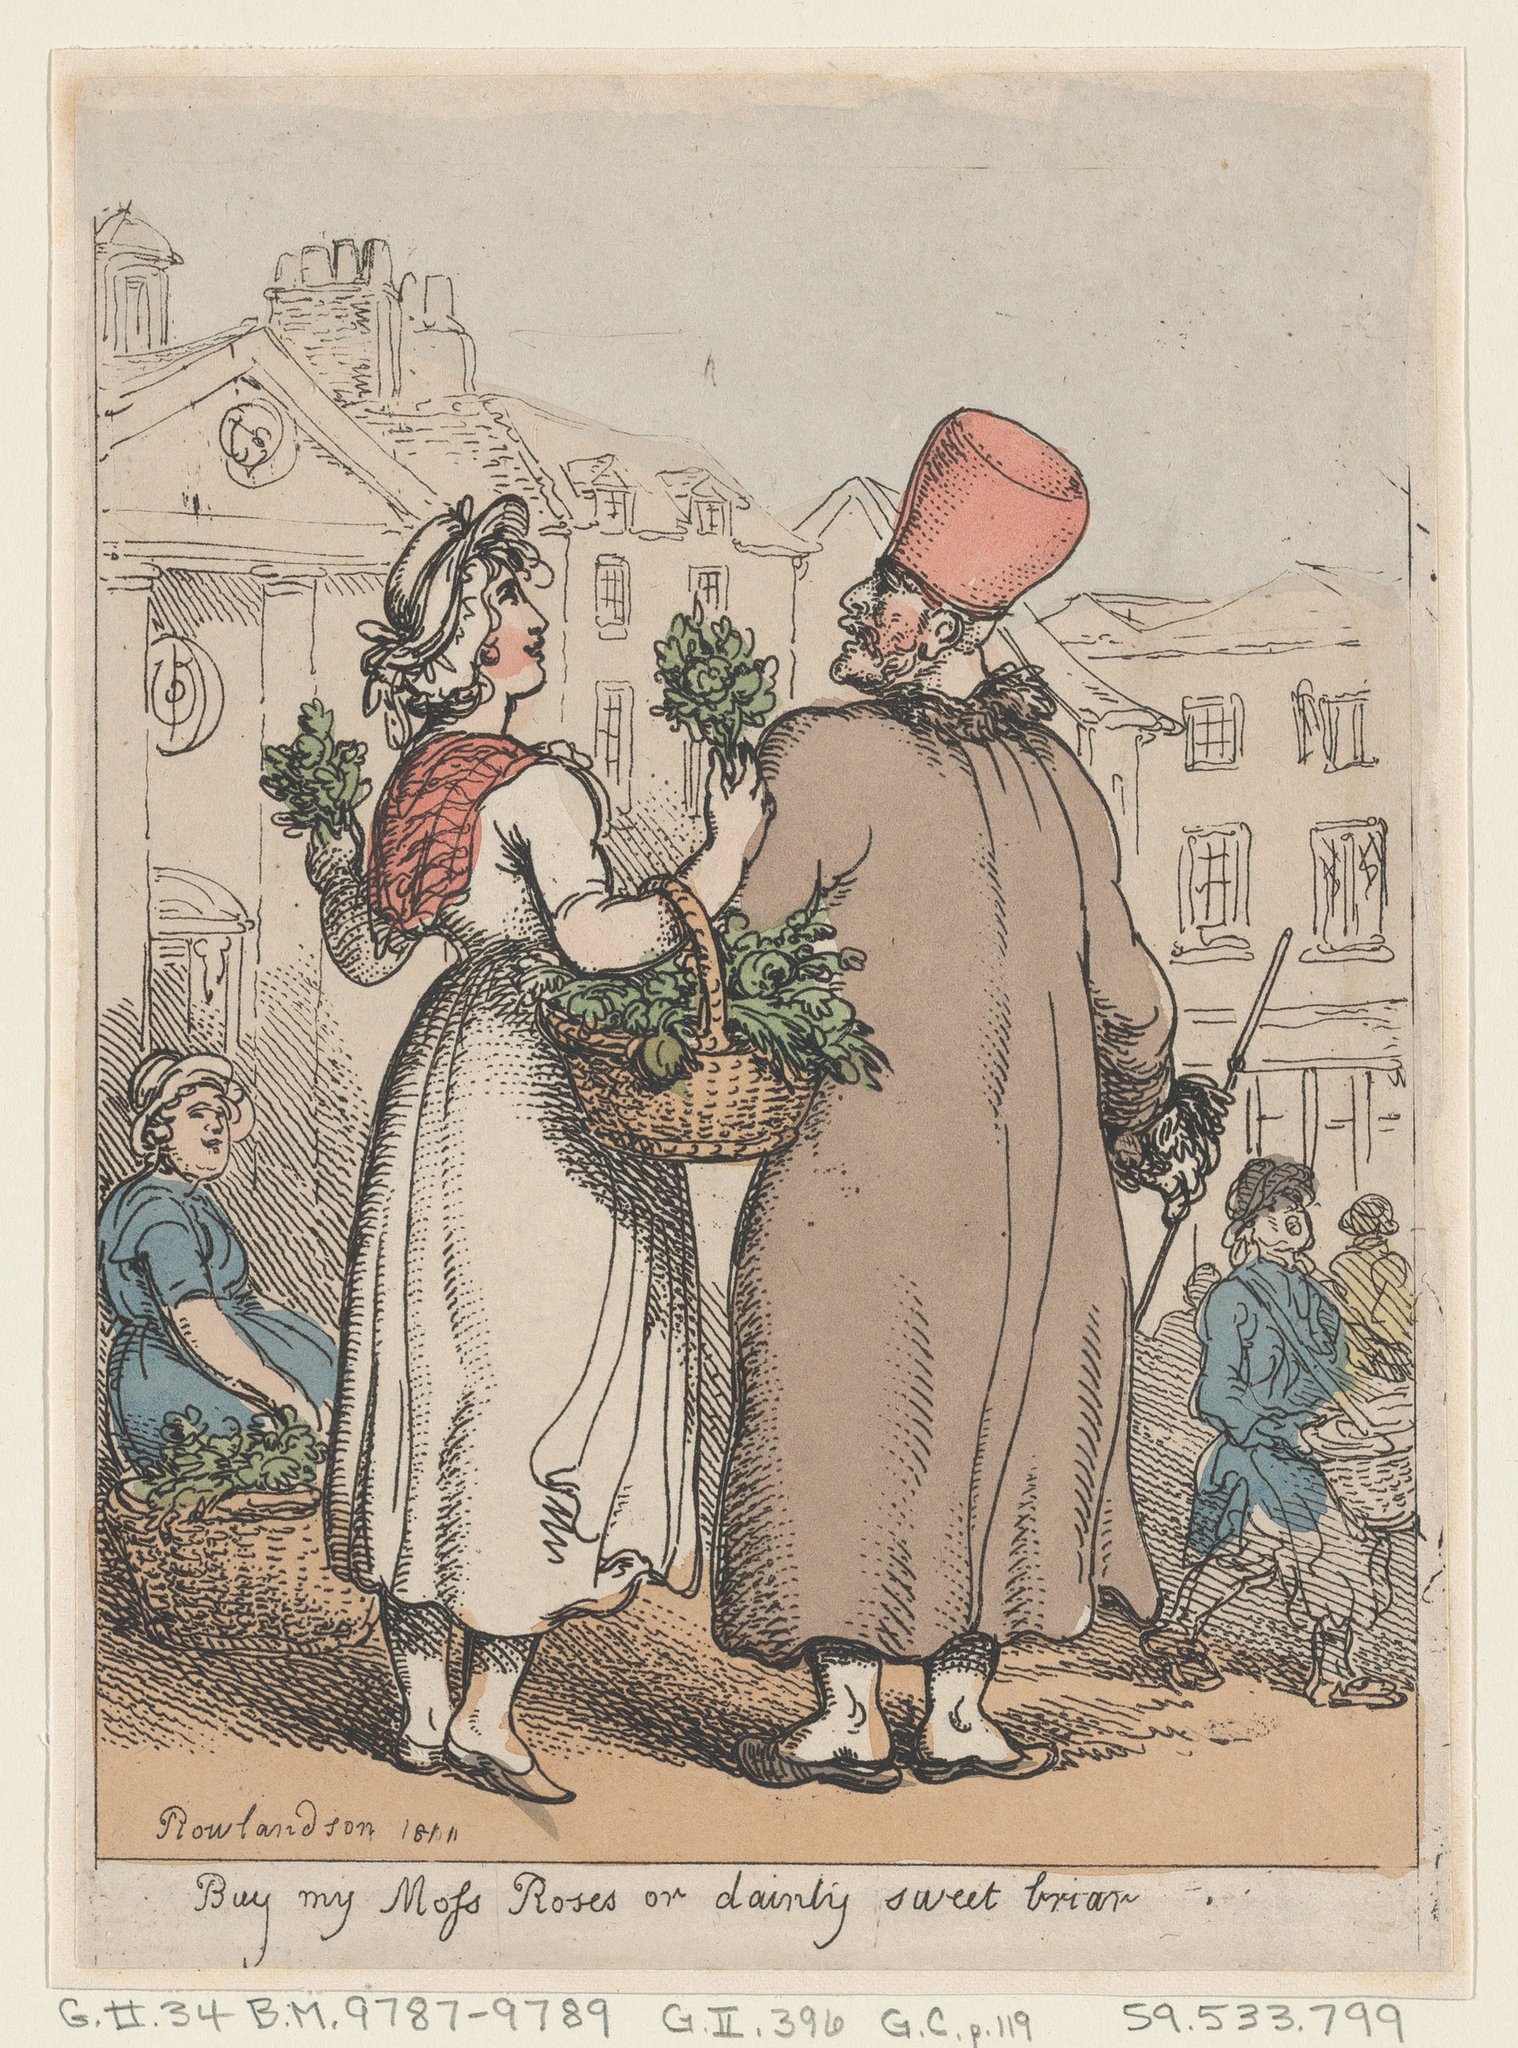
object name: print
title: Buy My Moss Roses, or Dainty Sweetbriar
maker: thomas rowlandson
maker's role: artist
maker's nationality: british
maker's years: 1757-1827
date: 1811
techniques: etching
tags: satire,men,women